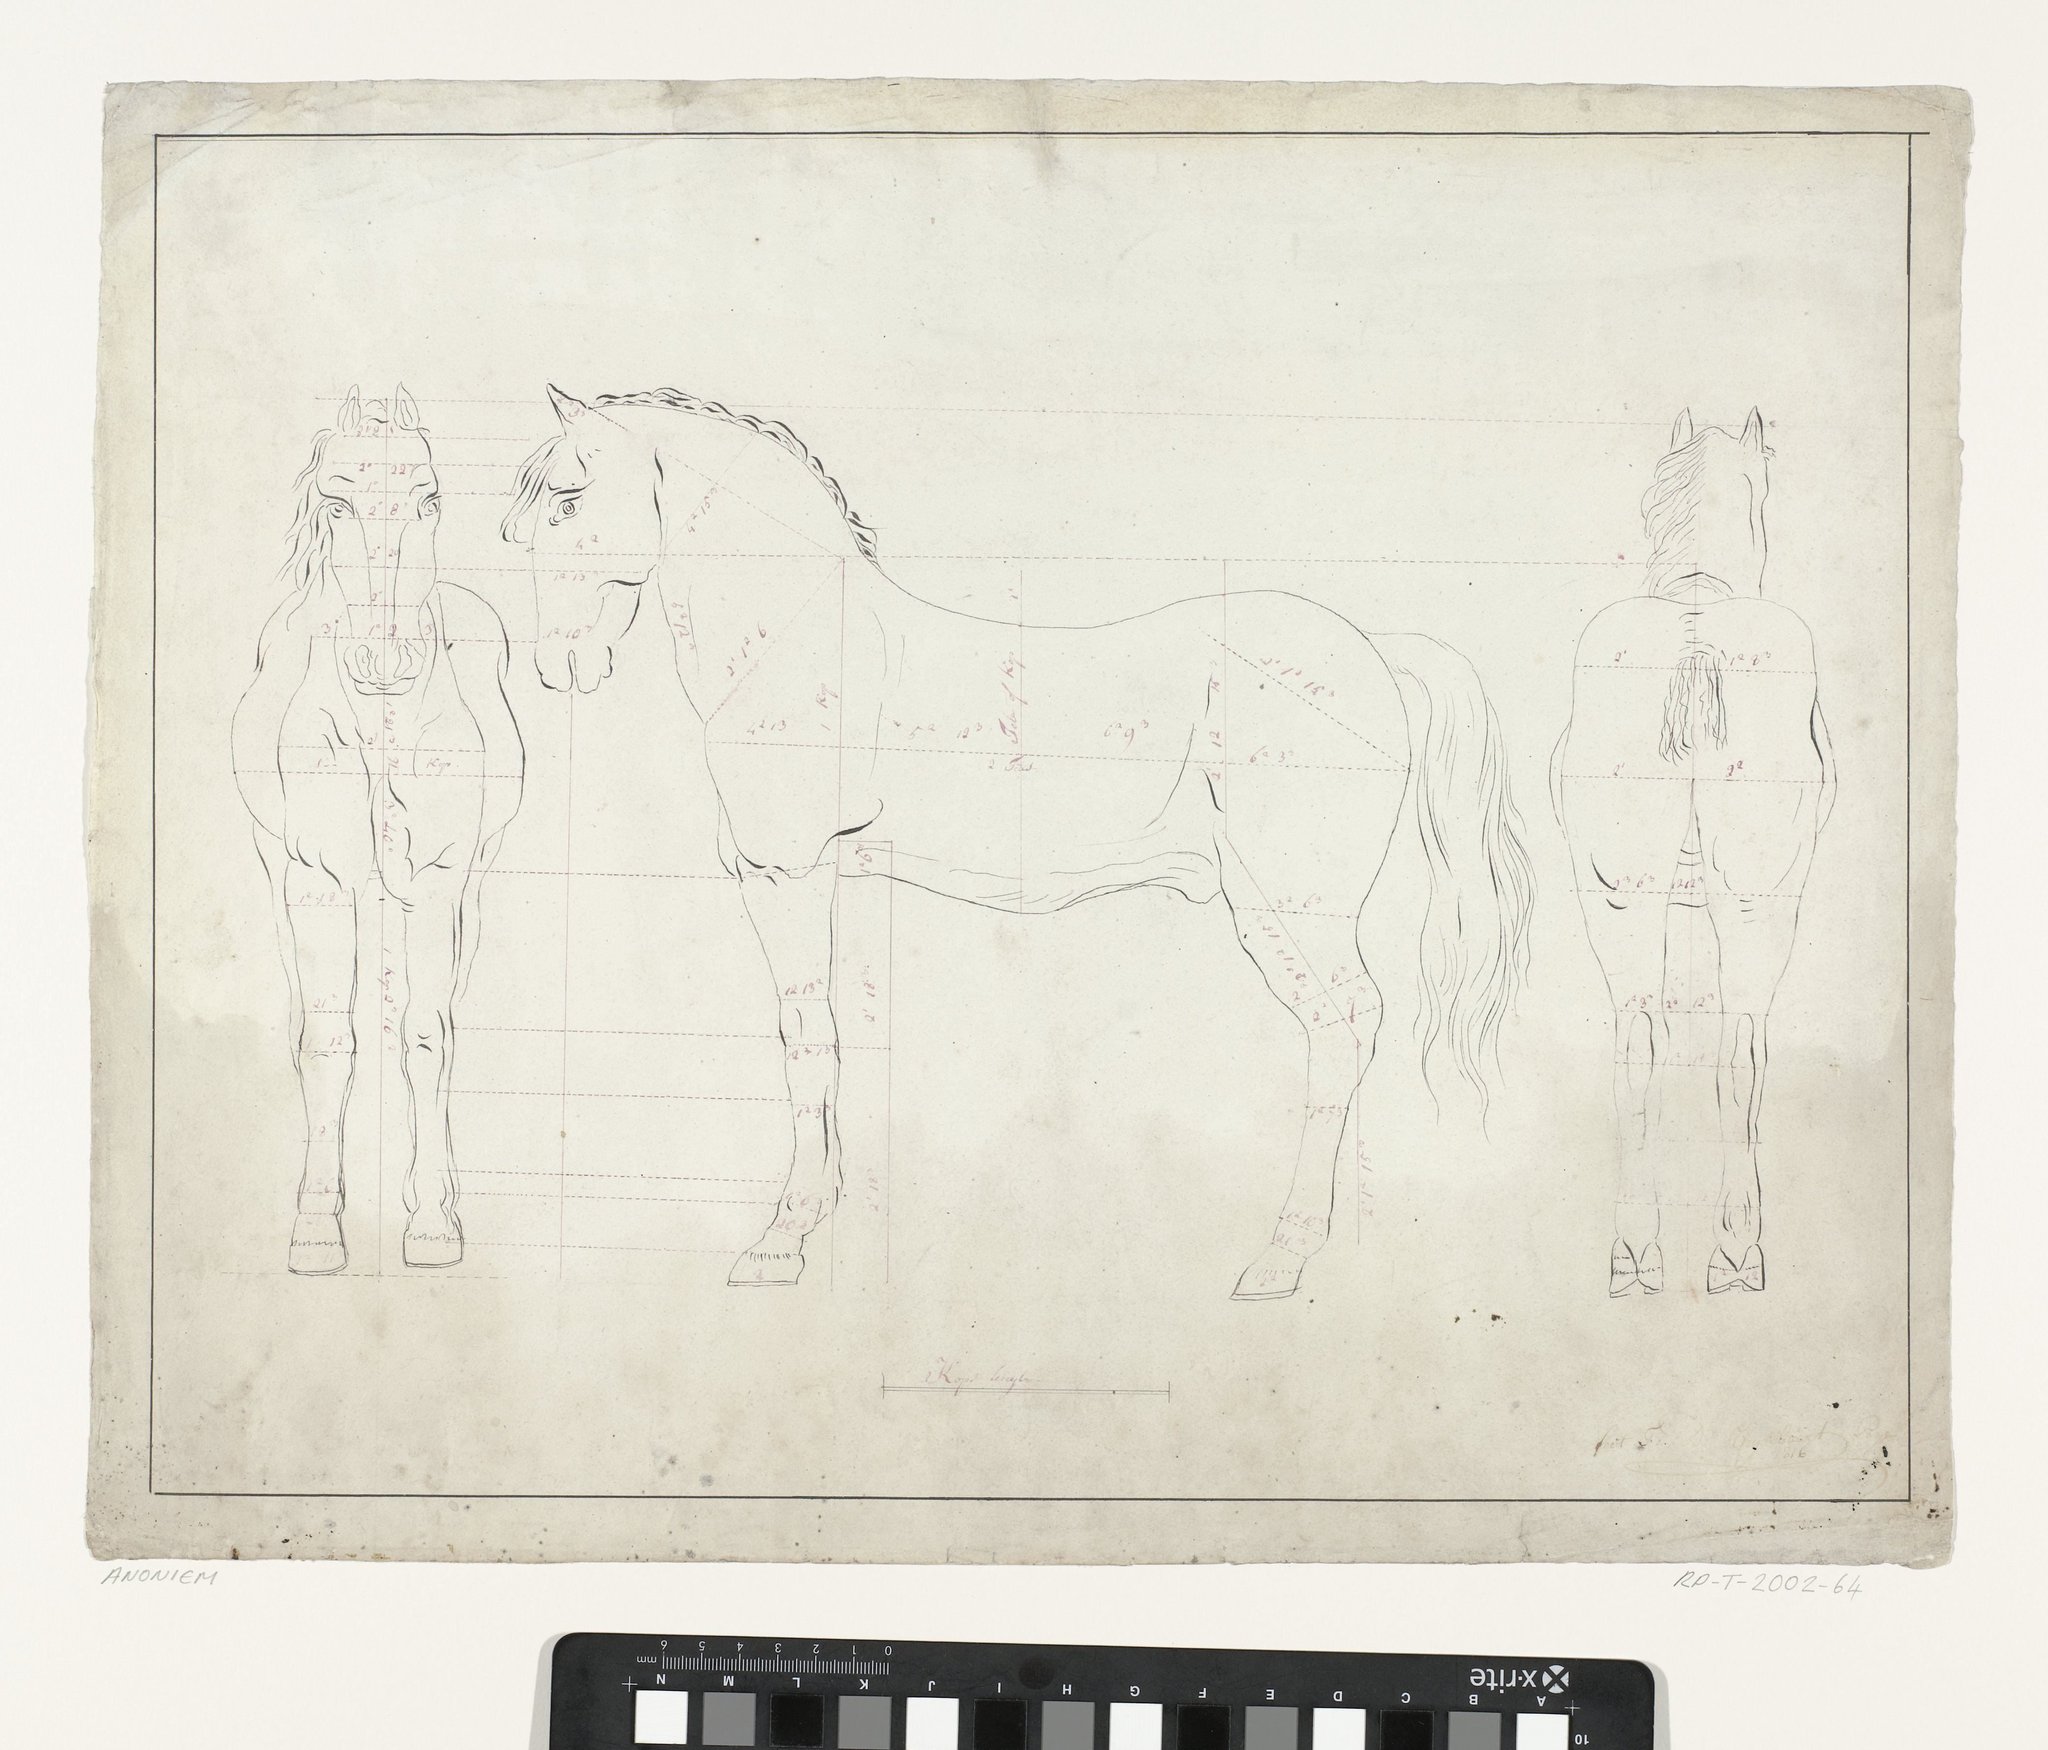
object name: drawing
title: Anatomische studie van een paard, van voren, in profiel naar links en van achteren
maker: Anonymous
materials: ink, paper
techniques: pen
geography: netherlands